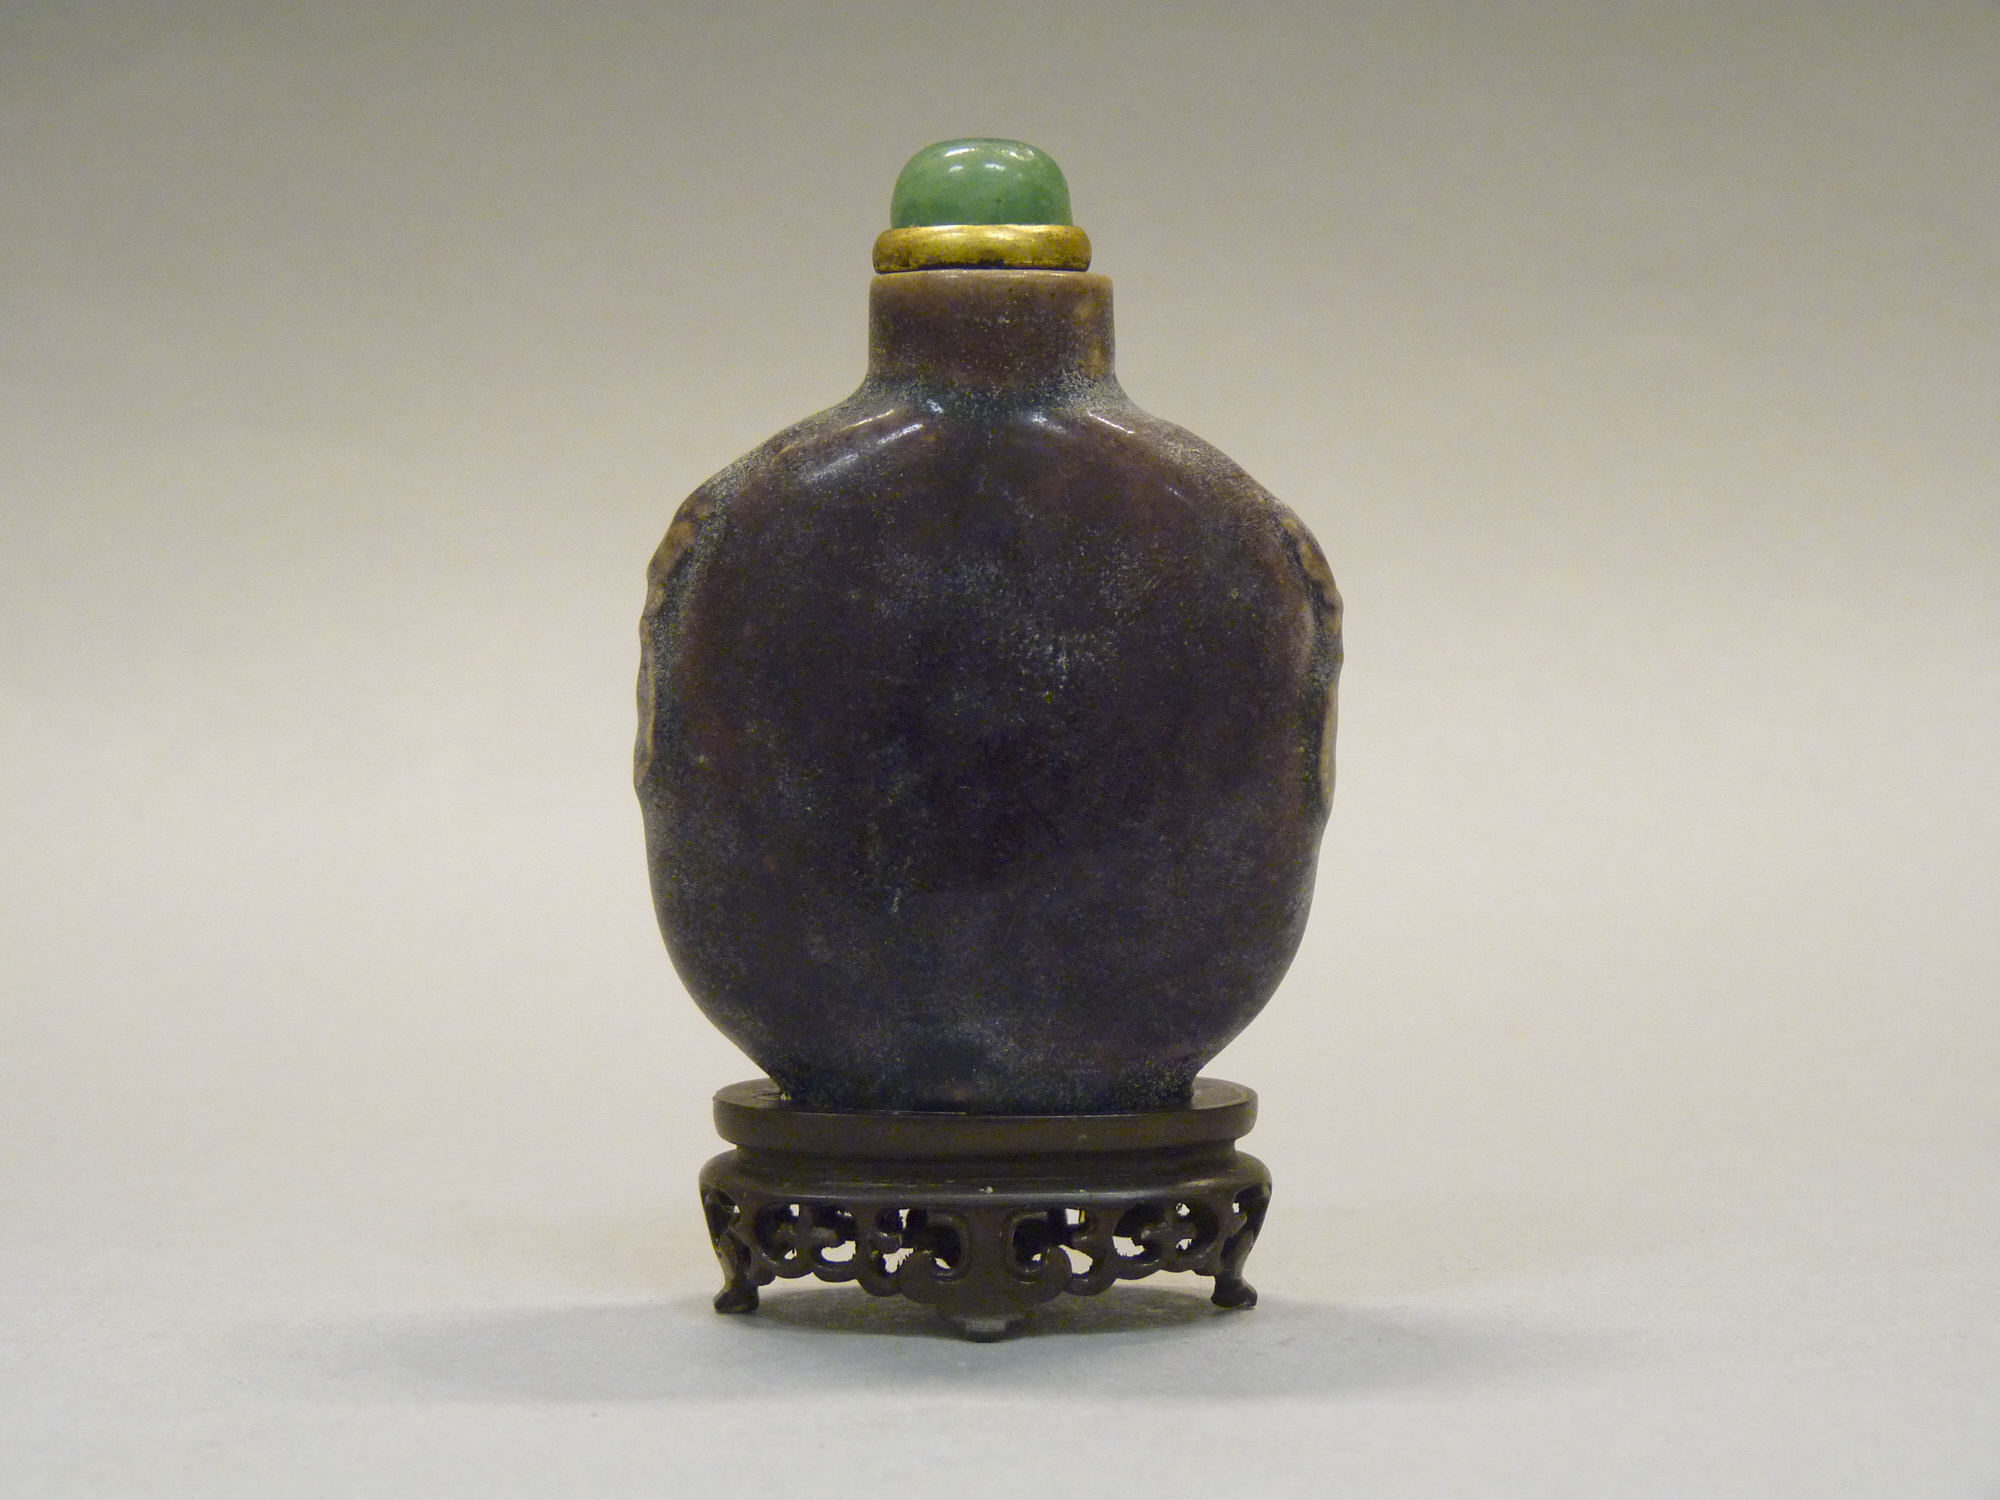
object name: snuff bottle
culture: chinese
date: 1736-1795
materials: jade, pottery